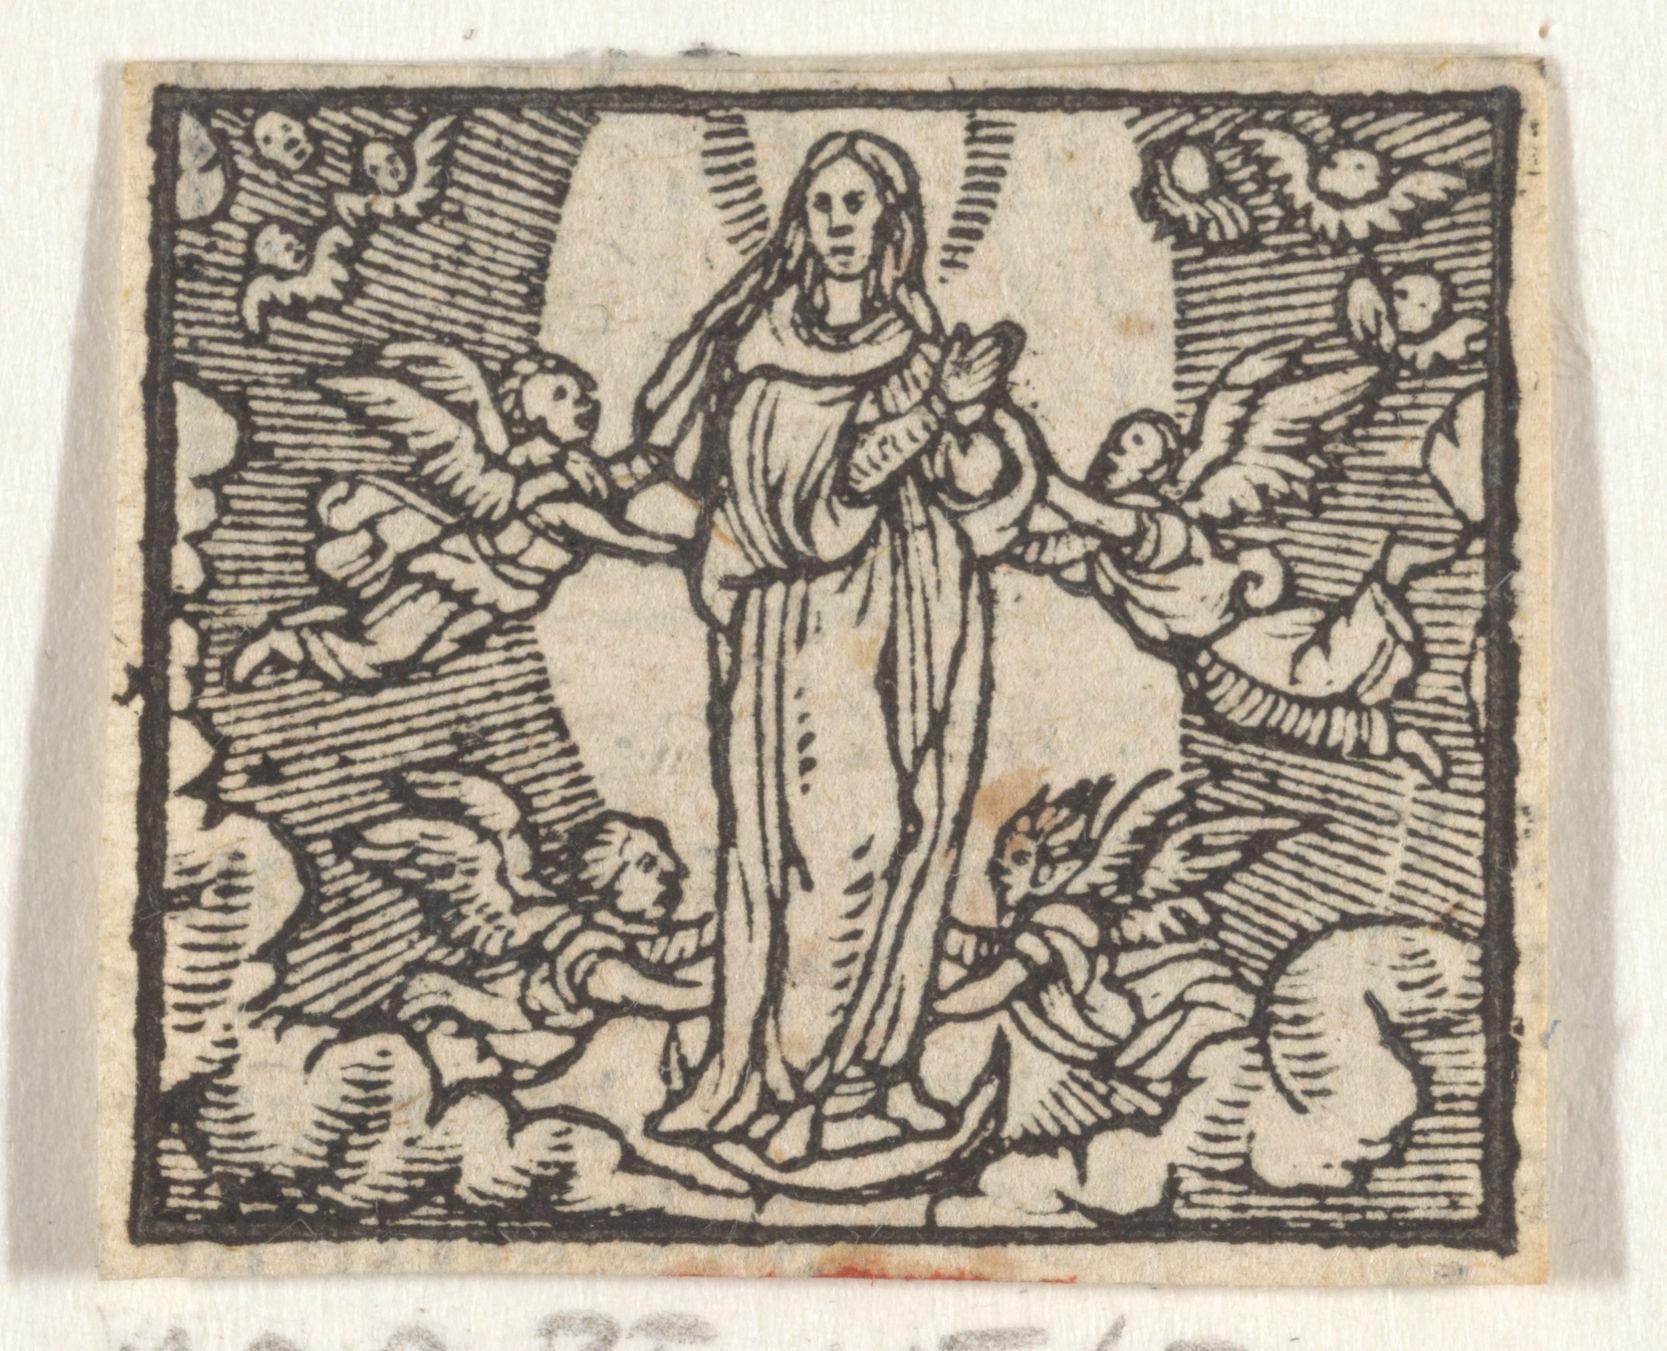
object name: print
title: Hemelvaart van Maria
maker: Anonymous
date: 1600-1699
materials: paper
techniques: letterpress printing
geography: netherlands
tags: the assumption of mary ('assumptio corporis'): she is borne into heaven by angels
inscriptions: collector's mark: Lugt 240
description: Maria wordt door engelen meegevoerd naar de hemel.